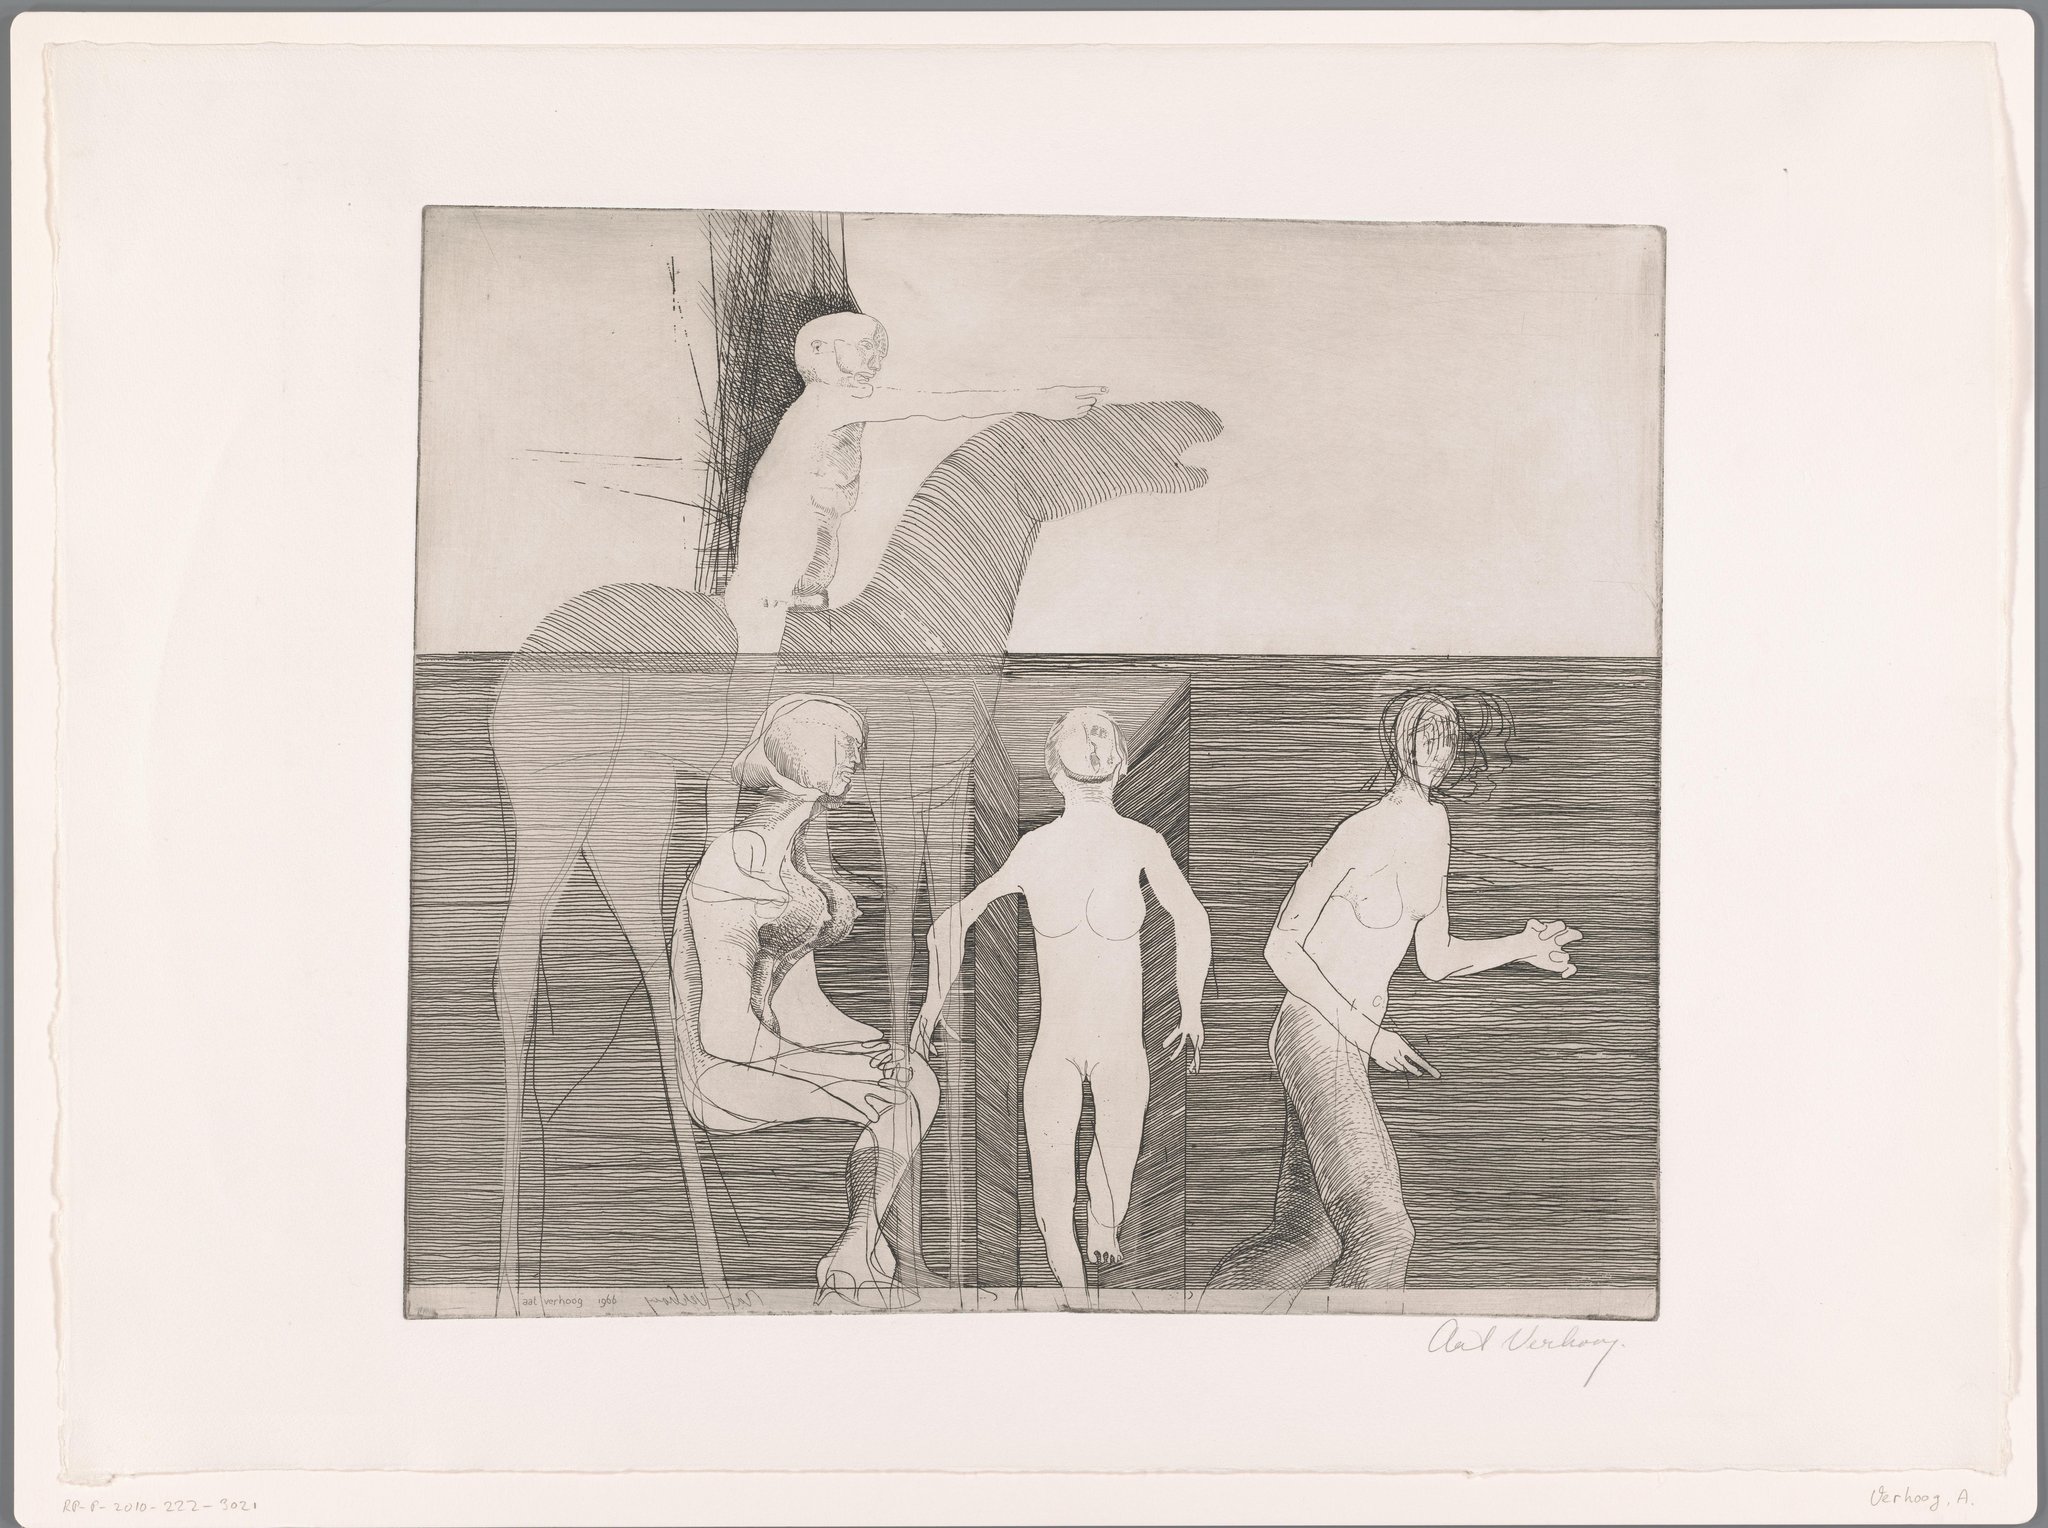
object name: print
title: Drie naakten en ruiter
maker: aat verhoog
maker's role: print maker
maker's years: 1933-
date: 1966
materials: paper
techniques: etching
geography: amsterdam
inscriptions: signature and date: ‘aat verhoog 1966’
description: Drie vrouwelijke naakten onder ruiter te paard (eveneens naakt) met uitgestrekte arm.